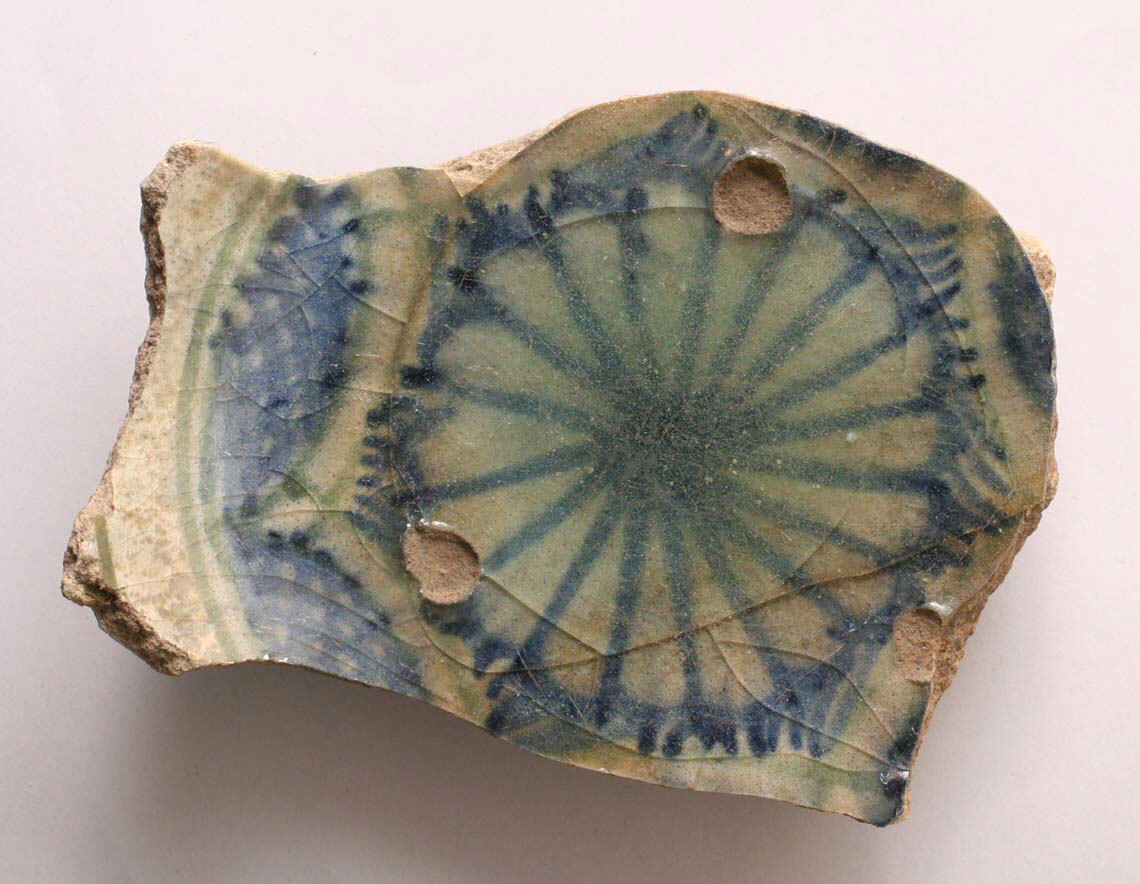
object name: fragment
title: Fragment of a Bowl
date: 1301-1500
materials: glaze, stonepaste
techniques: painting, polychrome, underglaze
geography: egypt